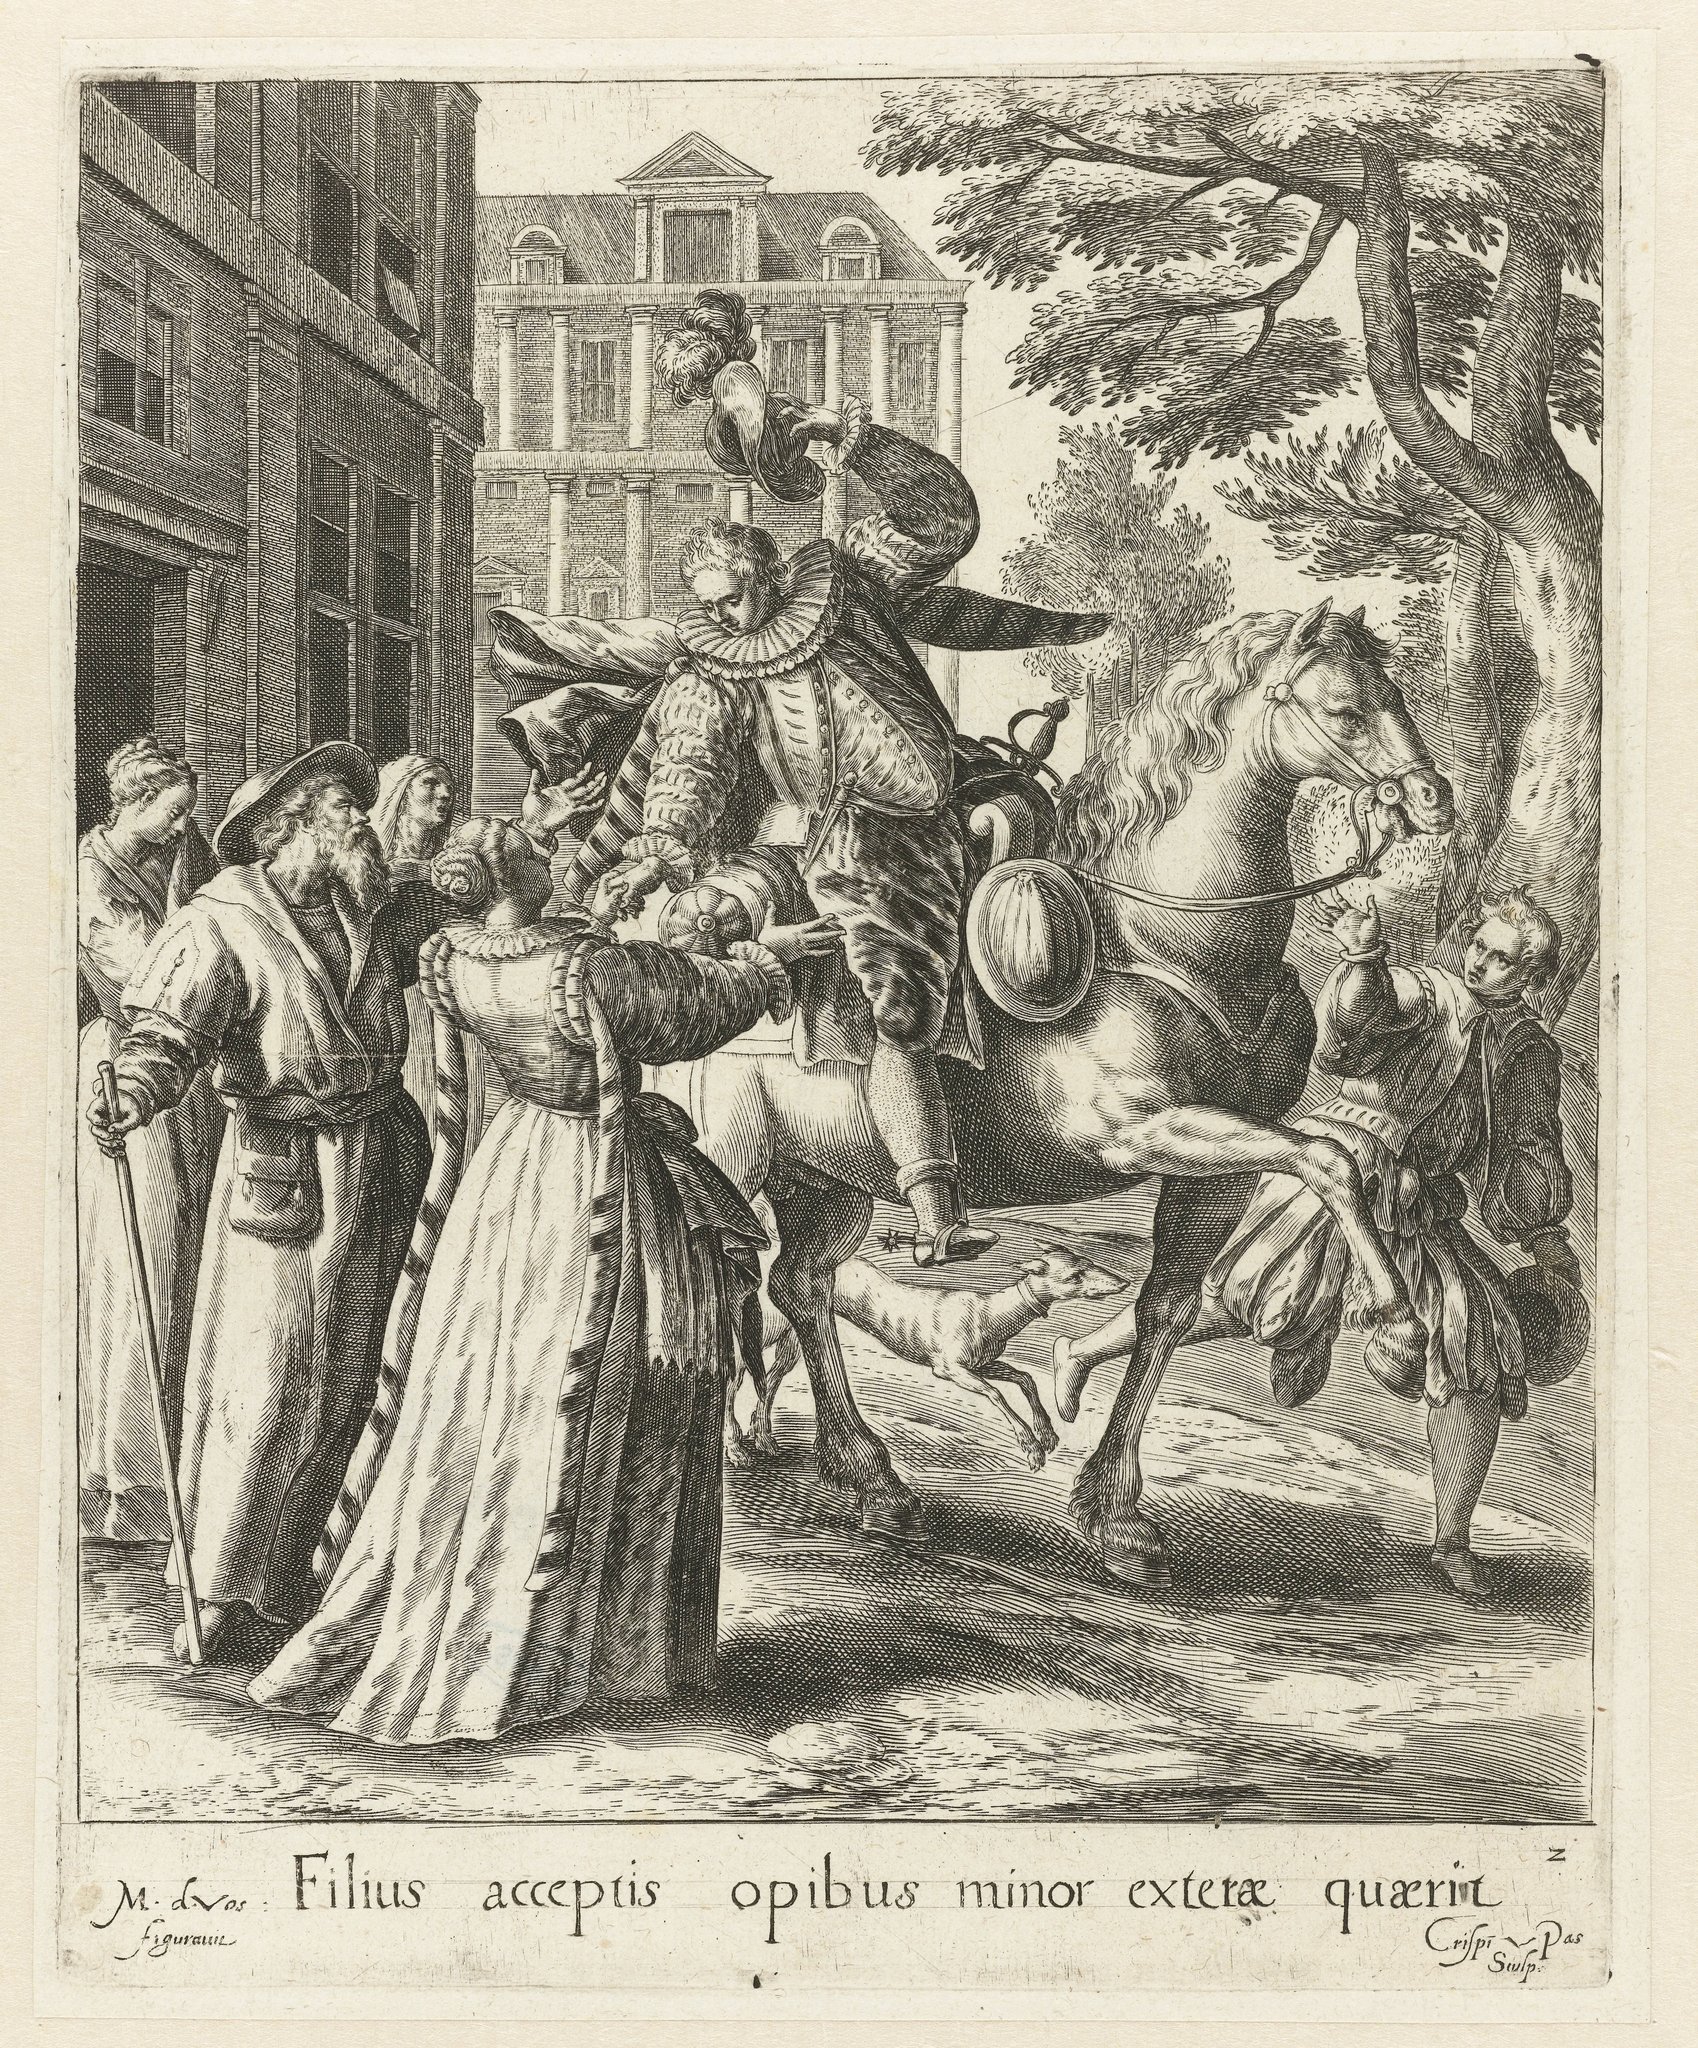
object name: print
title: Gelijkenis van de verloren zoon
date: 1580-1588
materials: paper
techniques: engraving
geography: antwerp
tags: riding a horse, ass, or mule; rider, horseman, neck-gear ~ clothing (with name) (+ men's clothes), clothing for the upper part of the body (with name) (+ men's clothes), sleeves, head-gear: hat (+ men's clothes), clothes, costume (+ women's clothes), dress, gown (+ women's clothes), clothes, costume (+ men's clothes), child (young man, young woman) leaving his (her) parents, leave-taking and departure of the prodigal son, low countries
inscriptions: collector's mark: Lugt 2228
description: De verloren zoon is gekleed volgens de adellijke mode van 1580-1590: wambuis met ganzenbuik* en molensteenkraag*, een hoed* zonder bol en slappe rand + veren in de hand. De vrouw van wie hij afscheid neemt is op de rug gezien. Zij draagt een overkleed met schouderkleppen* en loshangende mouwen*. De bediende naast het paard draagt een 'Pluderhosen'*. De oude man is gekleed in lange mantel met een ceintuurtas* om zijn middel.